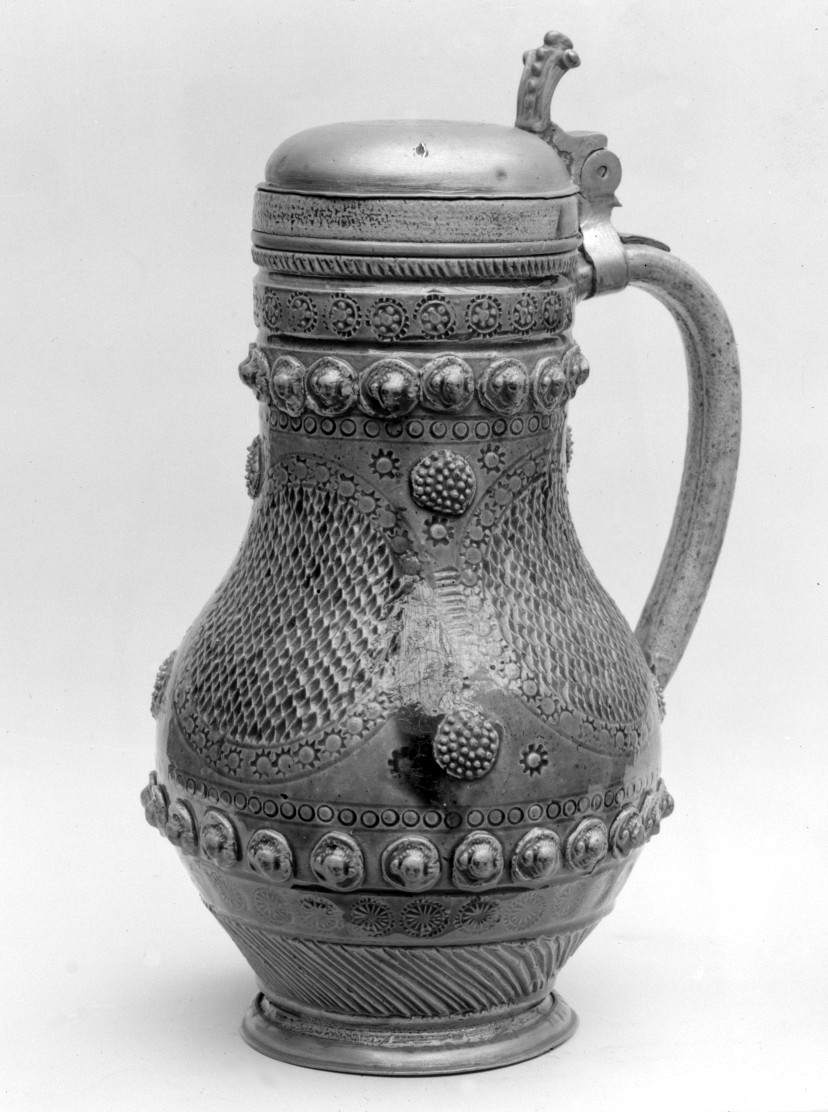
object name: tankard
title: Tankard (Kanne)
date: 1601-1700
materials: pewter, stoneware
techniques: salt glaze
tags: faces